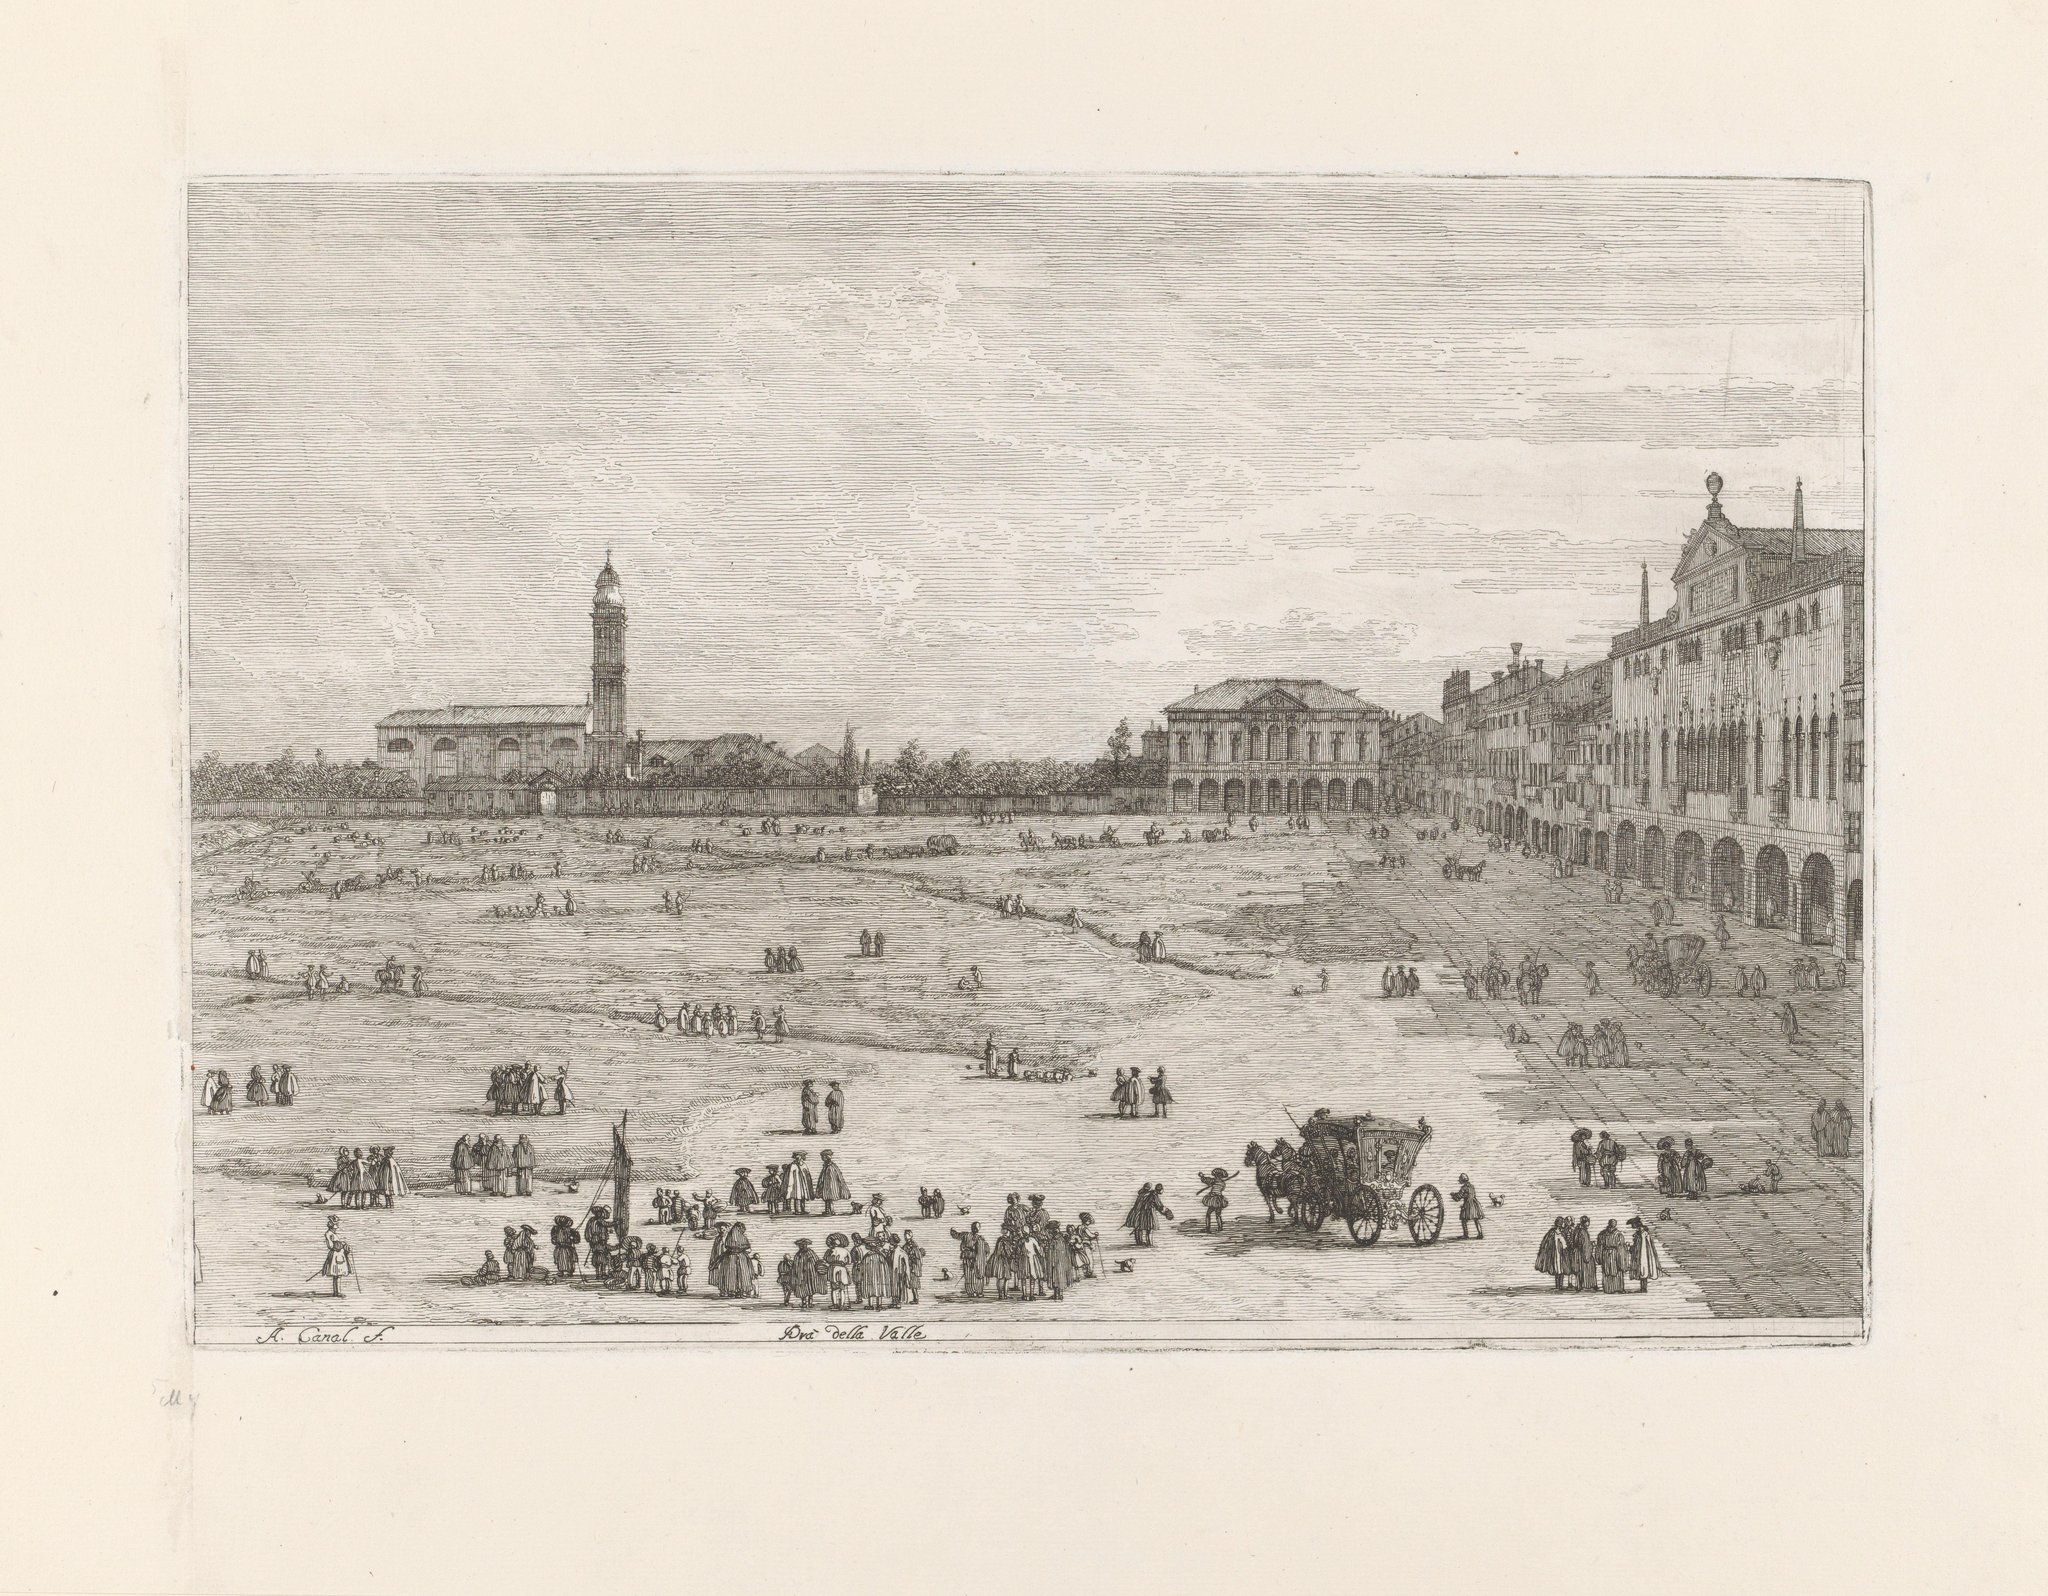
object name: print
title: Vedute altre prese da i Luoghi altre ideate da Antonio Canal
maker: canaletto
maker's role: draughtsman, painter, print maker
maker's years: 1697-1768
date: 1707-1768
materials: paper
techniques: etching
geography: venice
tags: square, place, circus, etc.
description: Gezicht op het stadsplein Prato della Valle te Padua. Op de achtergrond links de Chiesa della Misericordia. Rechts Palazzo Verson en het Colleggio Universitario.